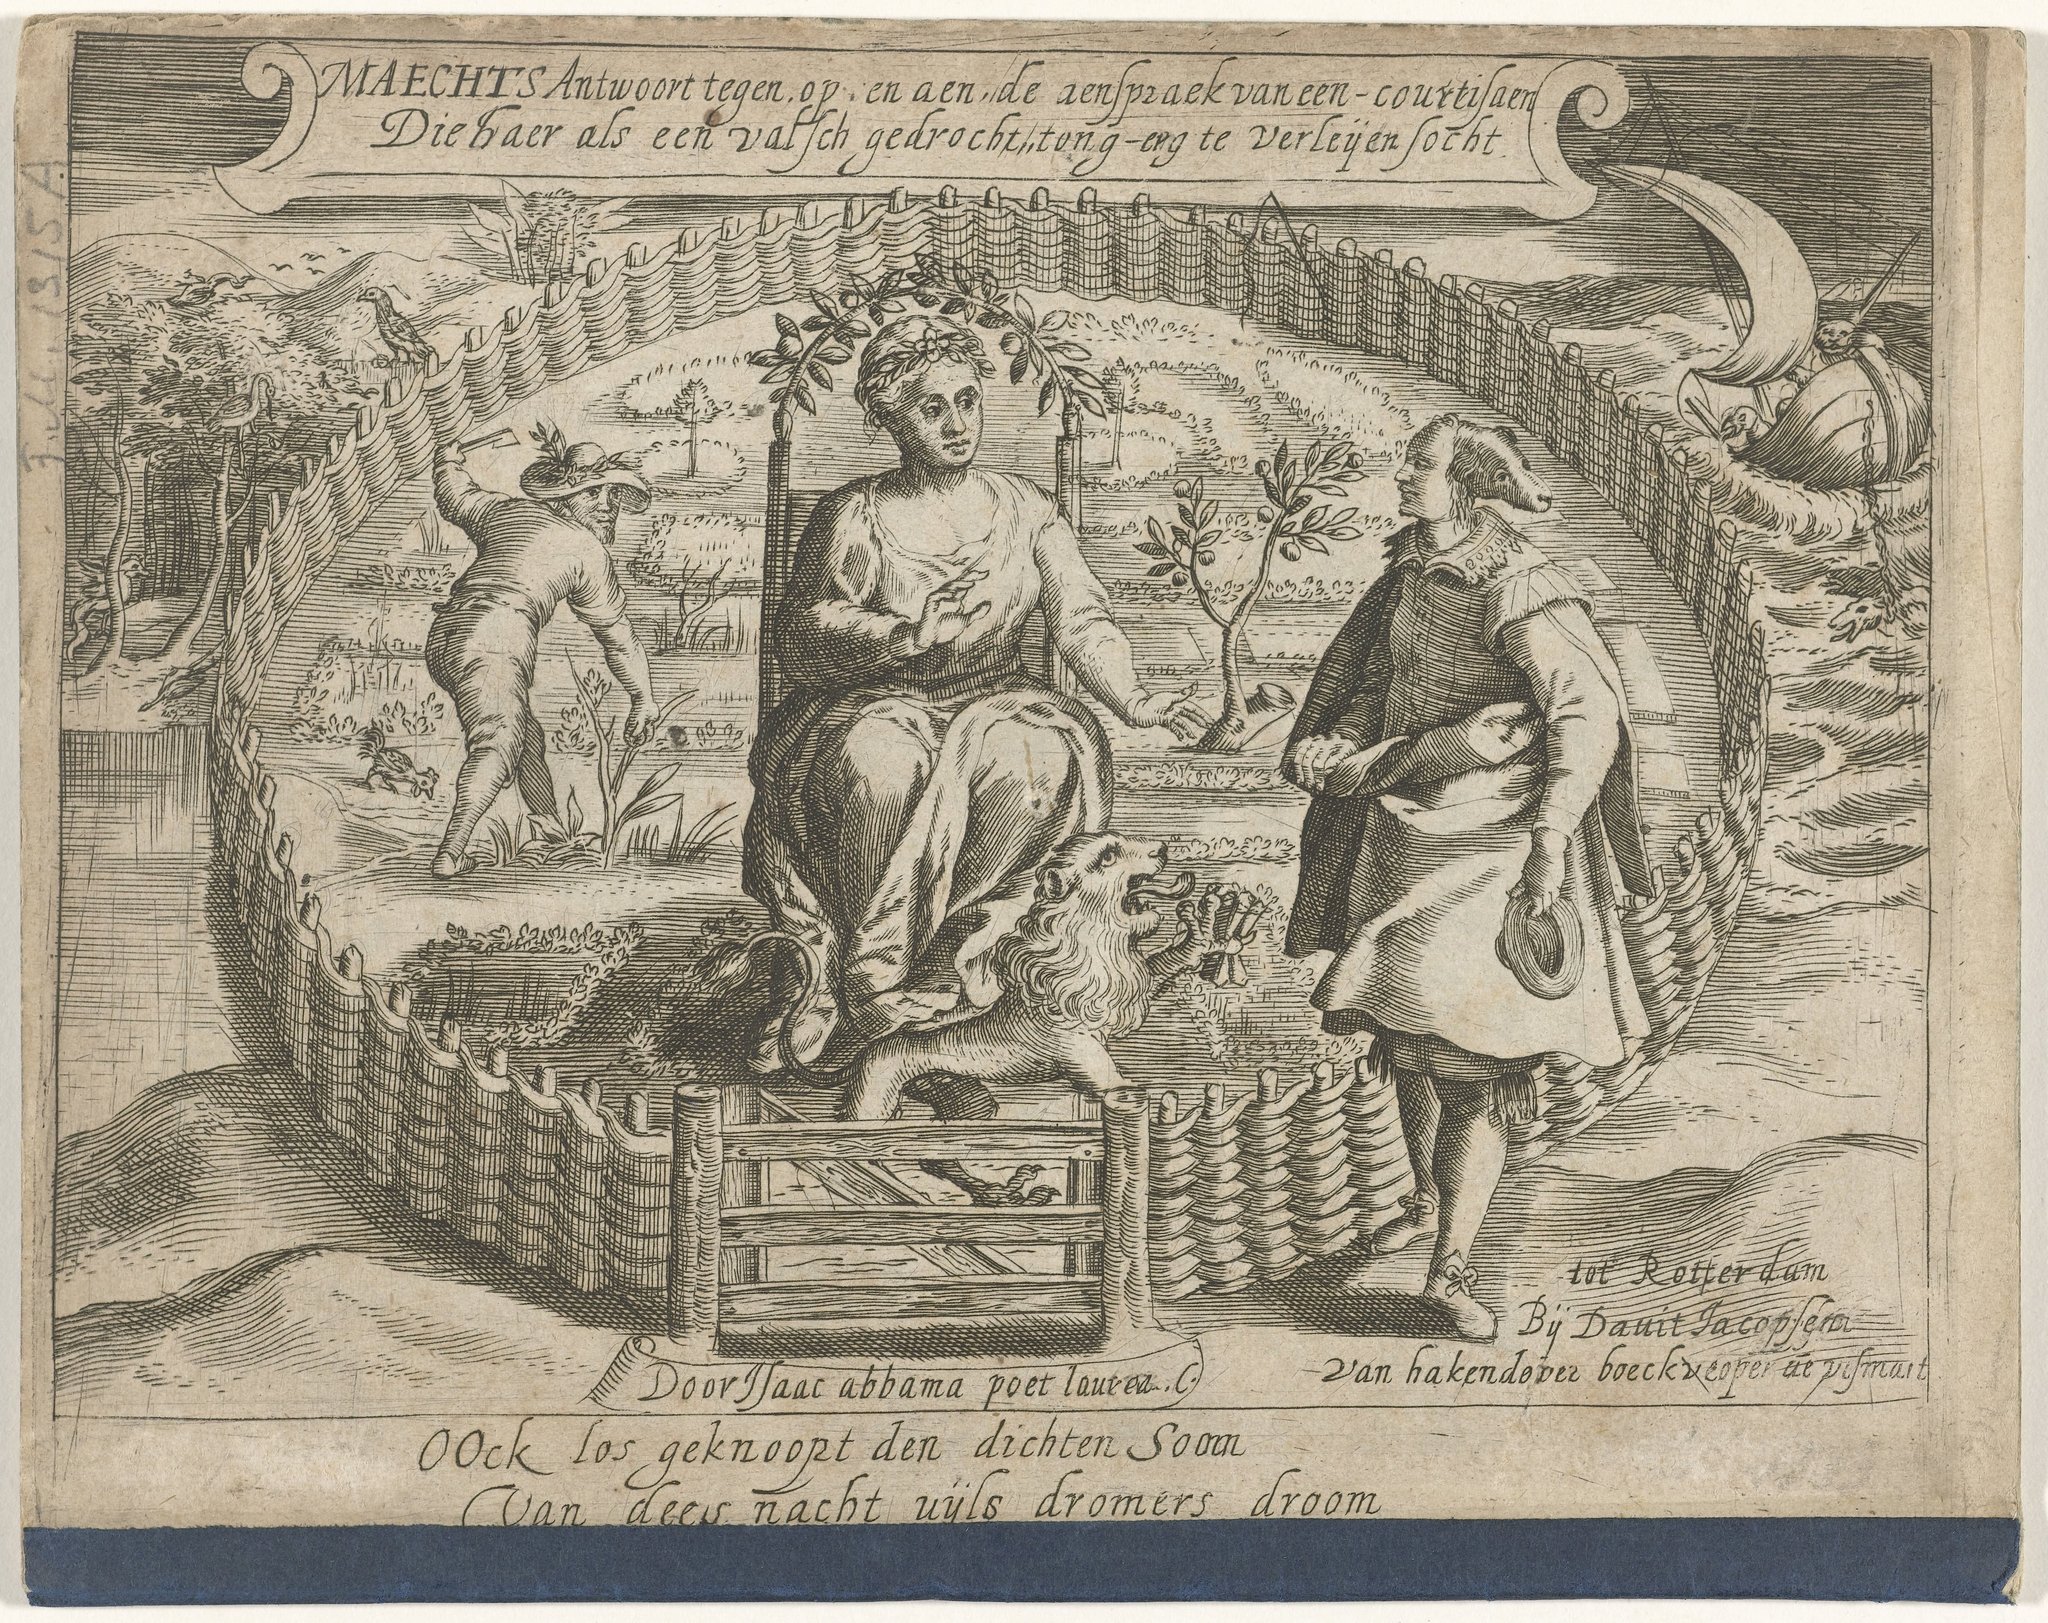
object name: pamphlet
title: Titelpagina van het pamflet: Maechts antwoort tegen, op, en aen, de aenspraeck van een courtisaen / Die haer als een valsch gedrocht, tong-erg te verleijen socht, 1617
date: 1617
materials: paper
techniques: engraving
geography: rotterdam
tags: the hague, maurice (prince of orange), personifications of countries, nations, states, districts, etc., fenced or walled garden; 'hortus conclusus', one-sided courting, netherlands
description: Titelblad van het pamflet met de vers: Maechts antwoort tegen, op, en aen, de aenspraeck van een courtisaen / Die haer als een valsch gedrocht, tong-erg te verleijen socht, 1617. Allegorie op de bedriegelijke vredesvoorstellen van Spanje. Een wolf, met masker vermond als jongeman, probeert de Hollandse Maagd te verleiden. De Hollandse Maagd zittend in de Hollandse Tuin, de Hollandse Leeuw bij de poort. In de tuin wiedt de hovenier prins Maurits het onkruid. Rechts een schip op zee, links een bos.